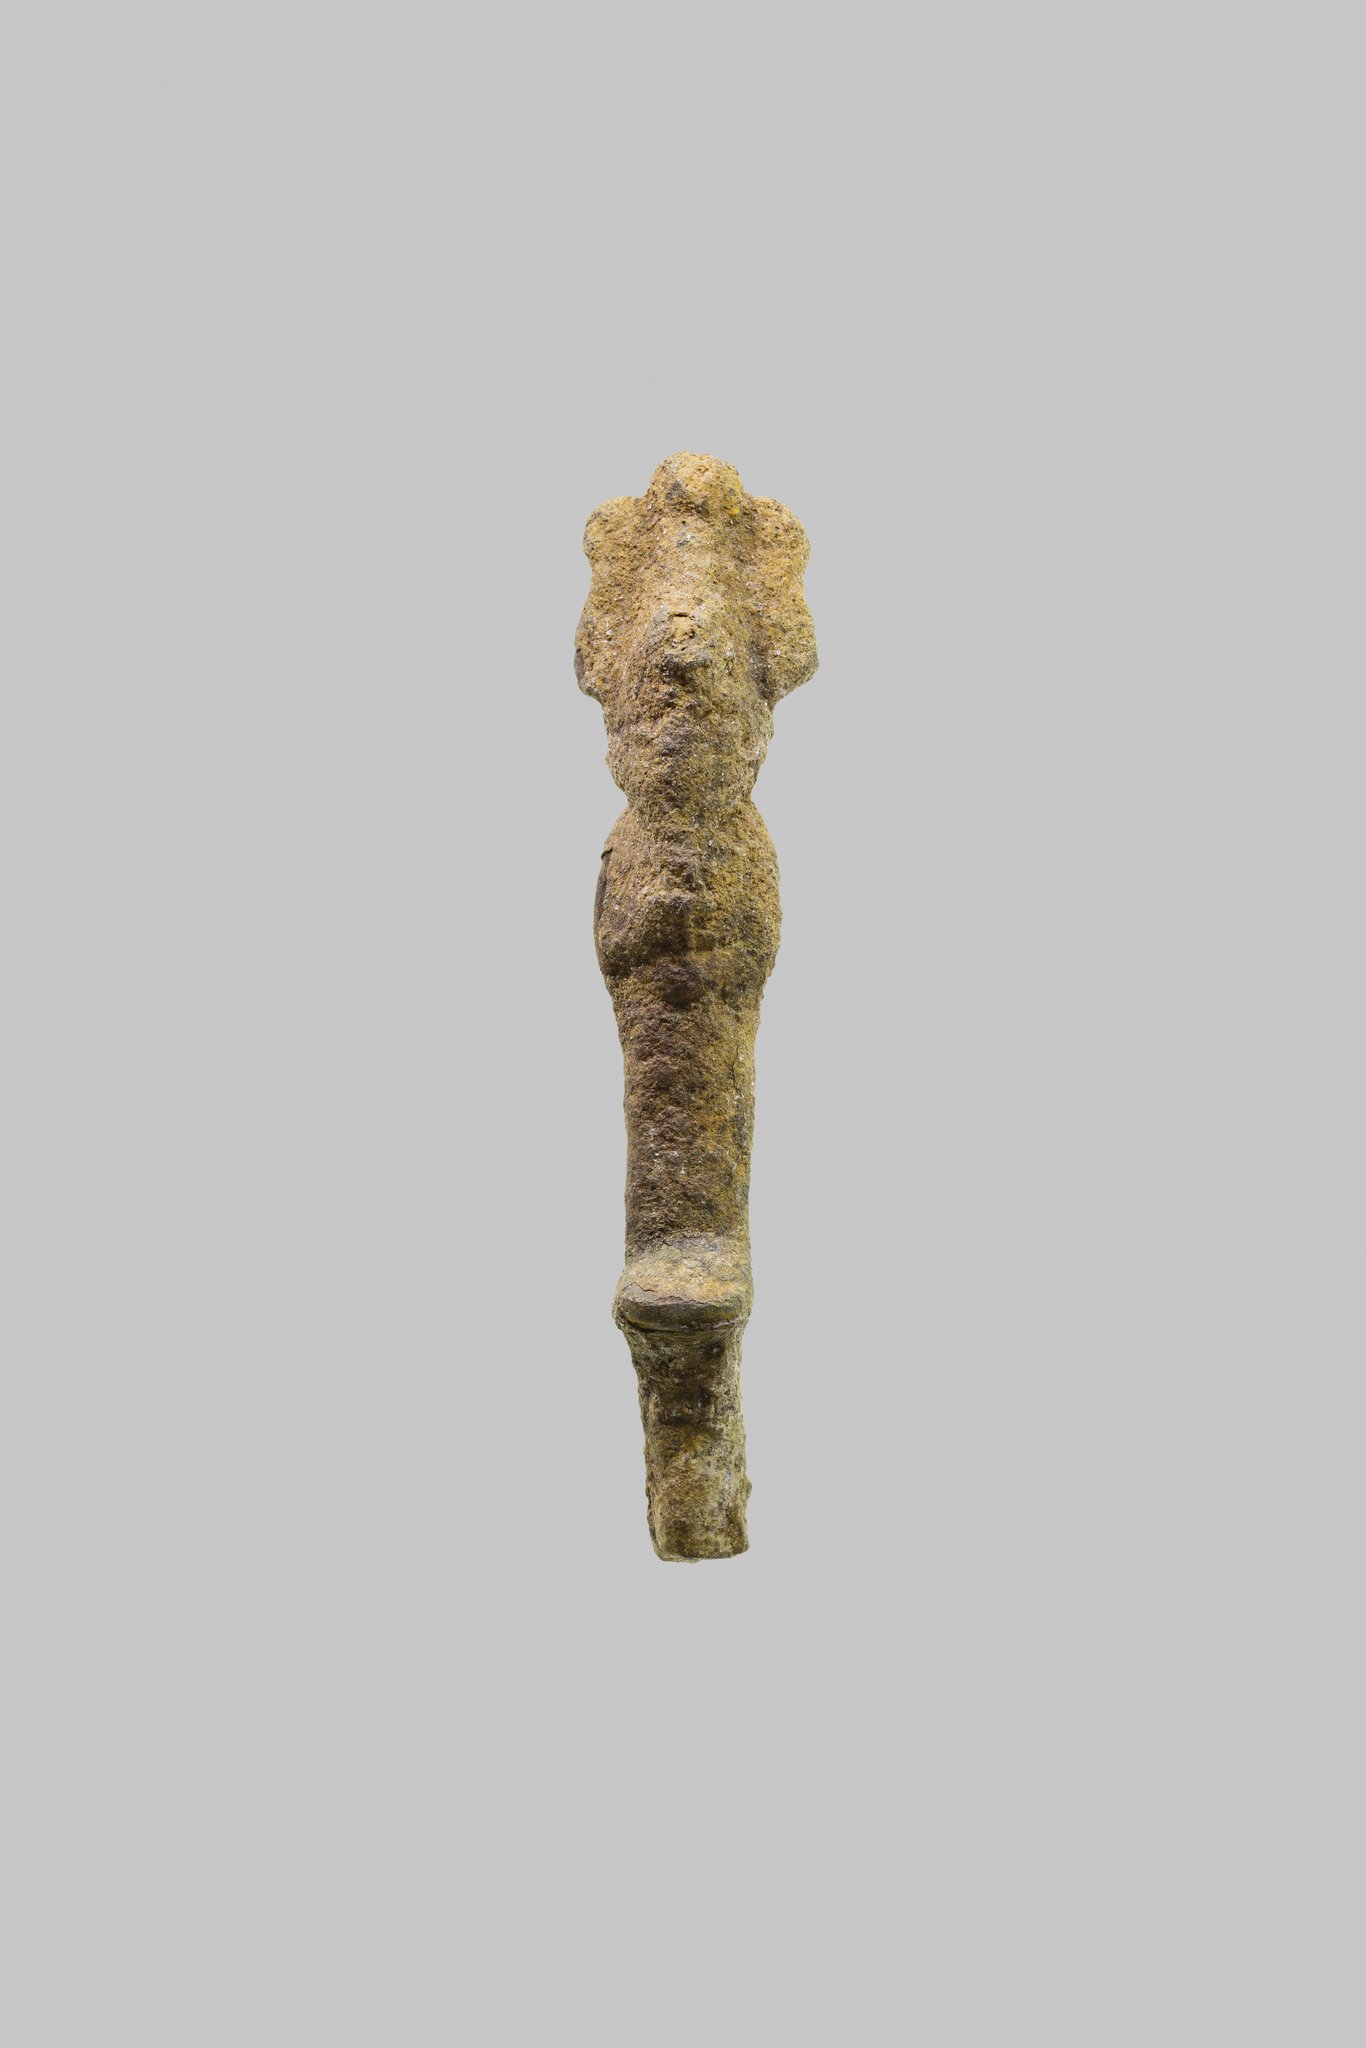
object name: statuette, osiris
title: Statuette of Osiris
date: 712-30 BCE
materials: bronze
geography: egypt